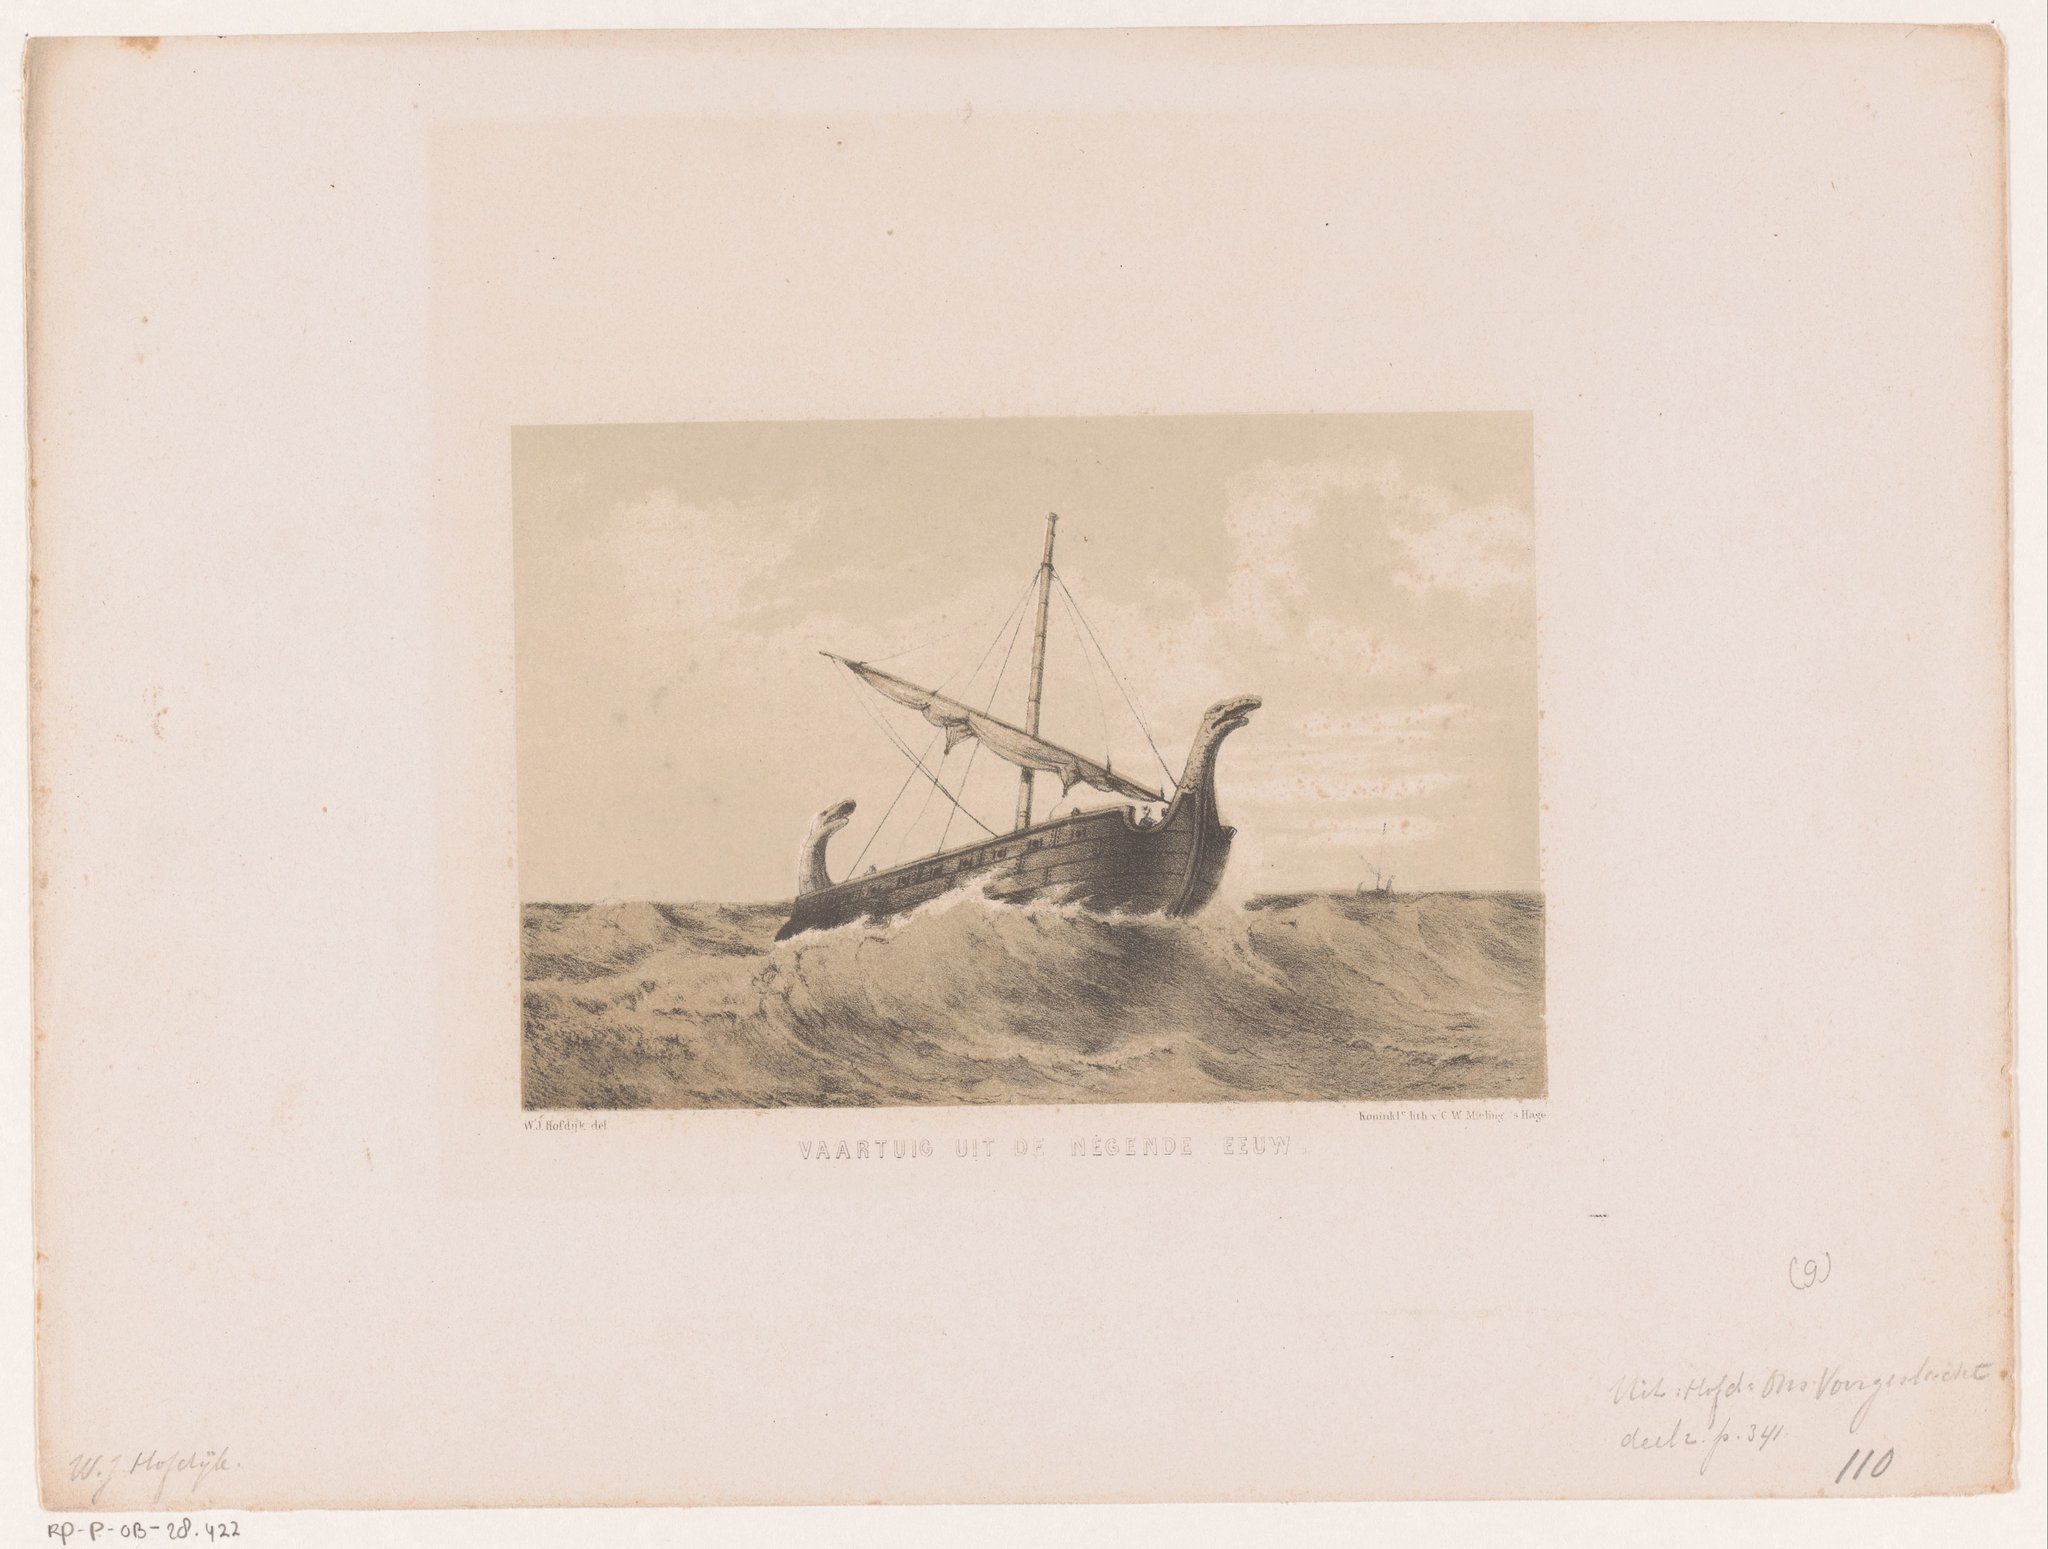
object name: print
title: Vaartuig, 9e eeuw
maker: willem jacob hofdijk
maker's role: painter, print maker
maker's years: 1816-1888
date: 1857-1864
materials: paper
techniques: tone lithography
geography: the hague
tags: ships (in general), netherlands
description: Illustratie voor: W.J. Hofdijk, Ons voorgeslacht in zijn dagelyksch leven geschilderd, Kruseman, Haarlem 1859-1864, dl. 2, p. 341.